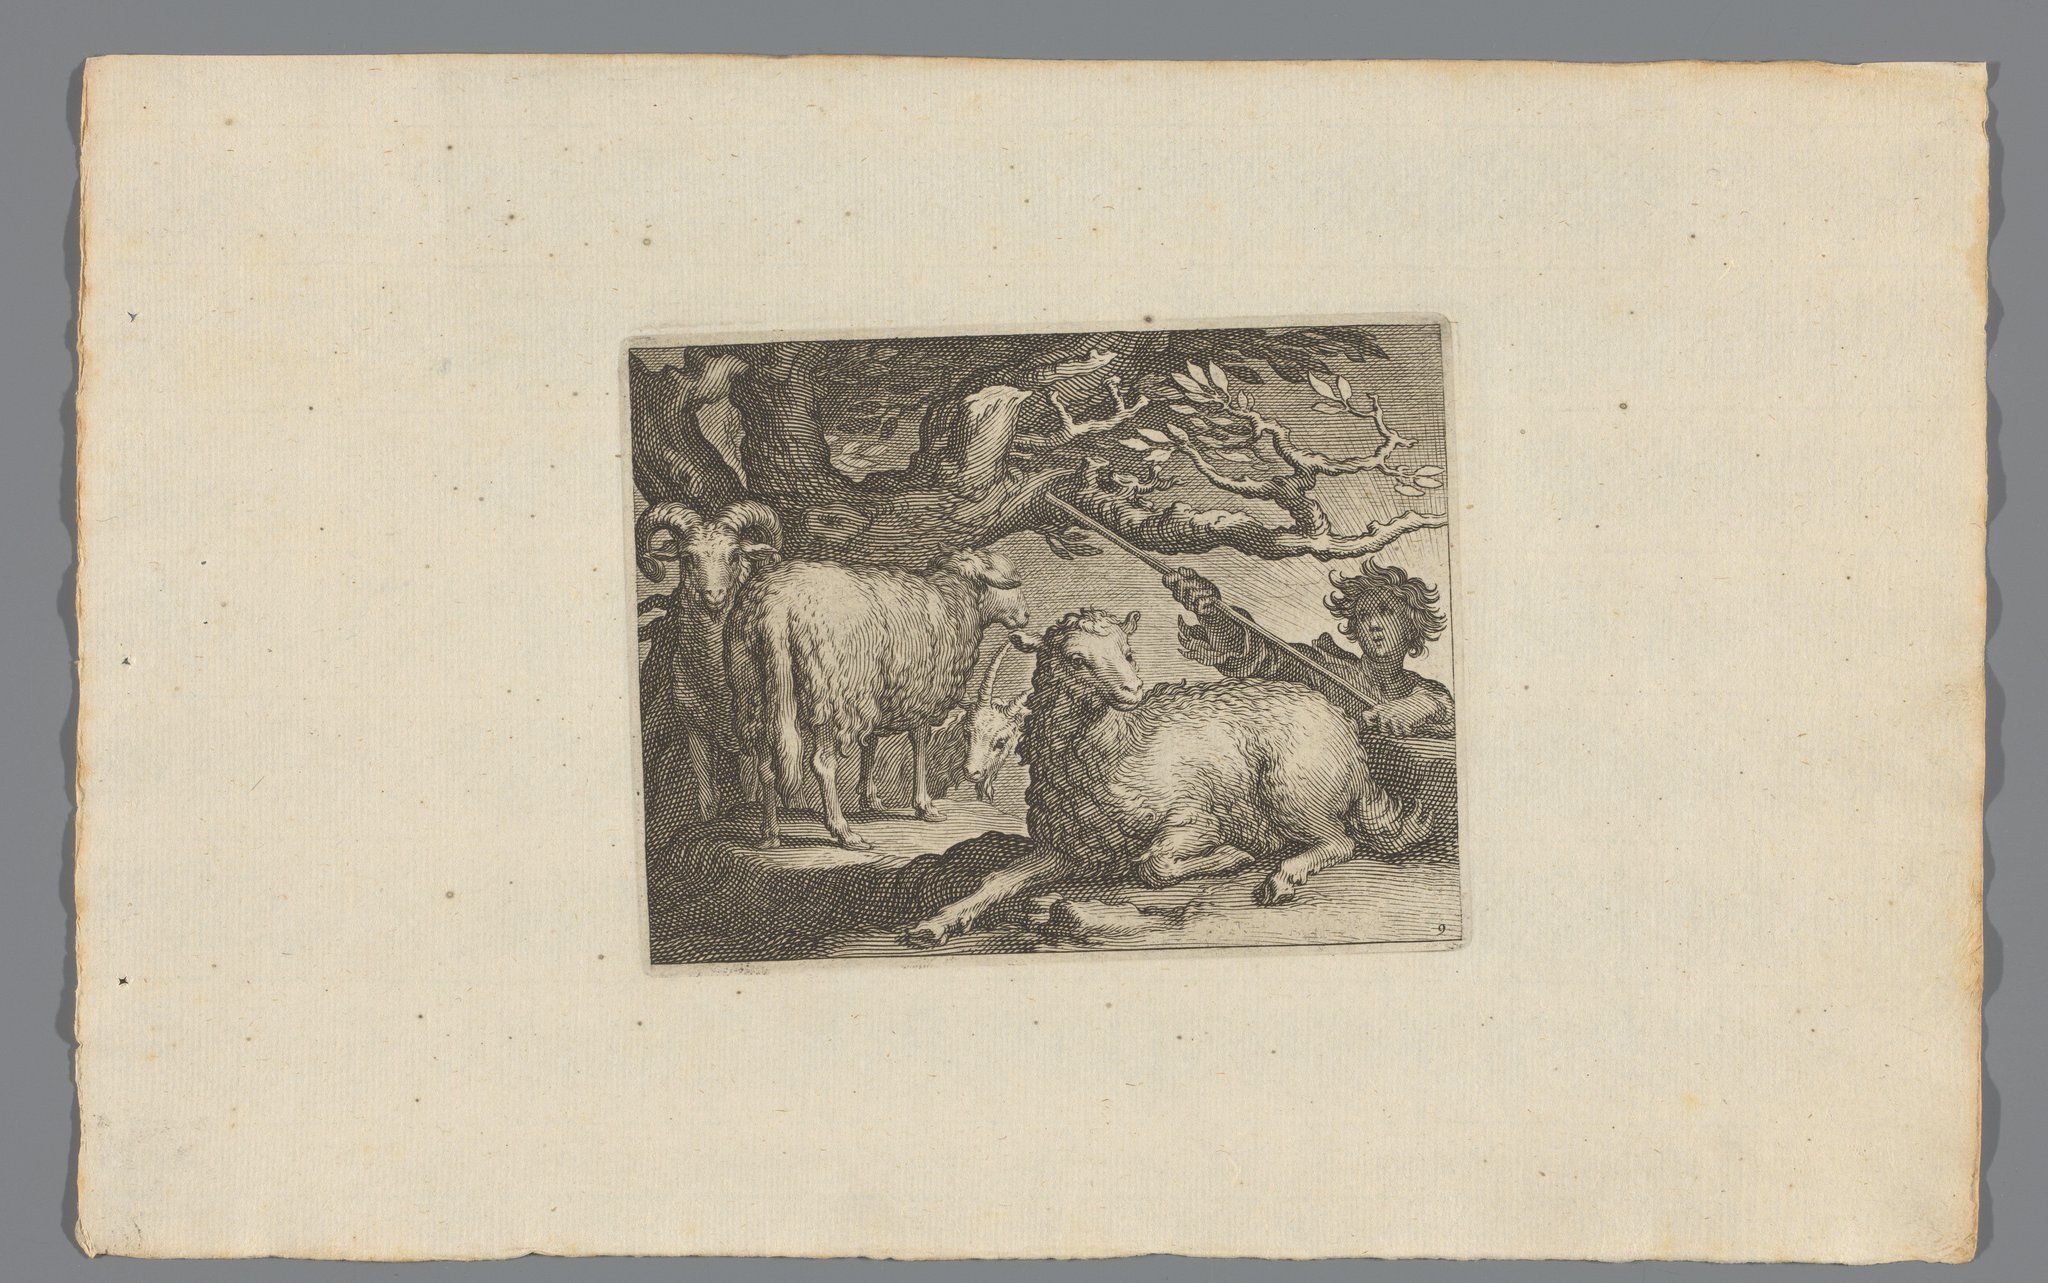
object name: print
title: Pastoralen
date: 1611-1632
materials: paper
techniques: engraving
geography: amsterdam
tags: herding, herdsman, herdswoman, shepherd, shepherdess, cowherd, etc., sheep, pastorals, arcadian scenes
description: Prent maakt deel uit van een serie van veertien prenten.